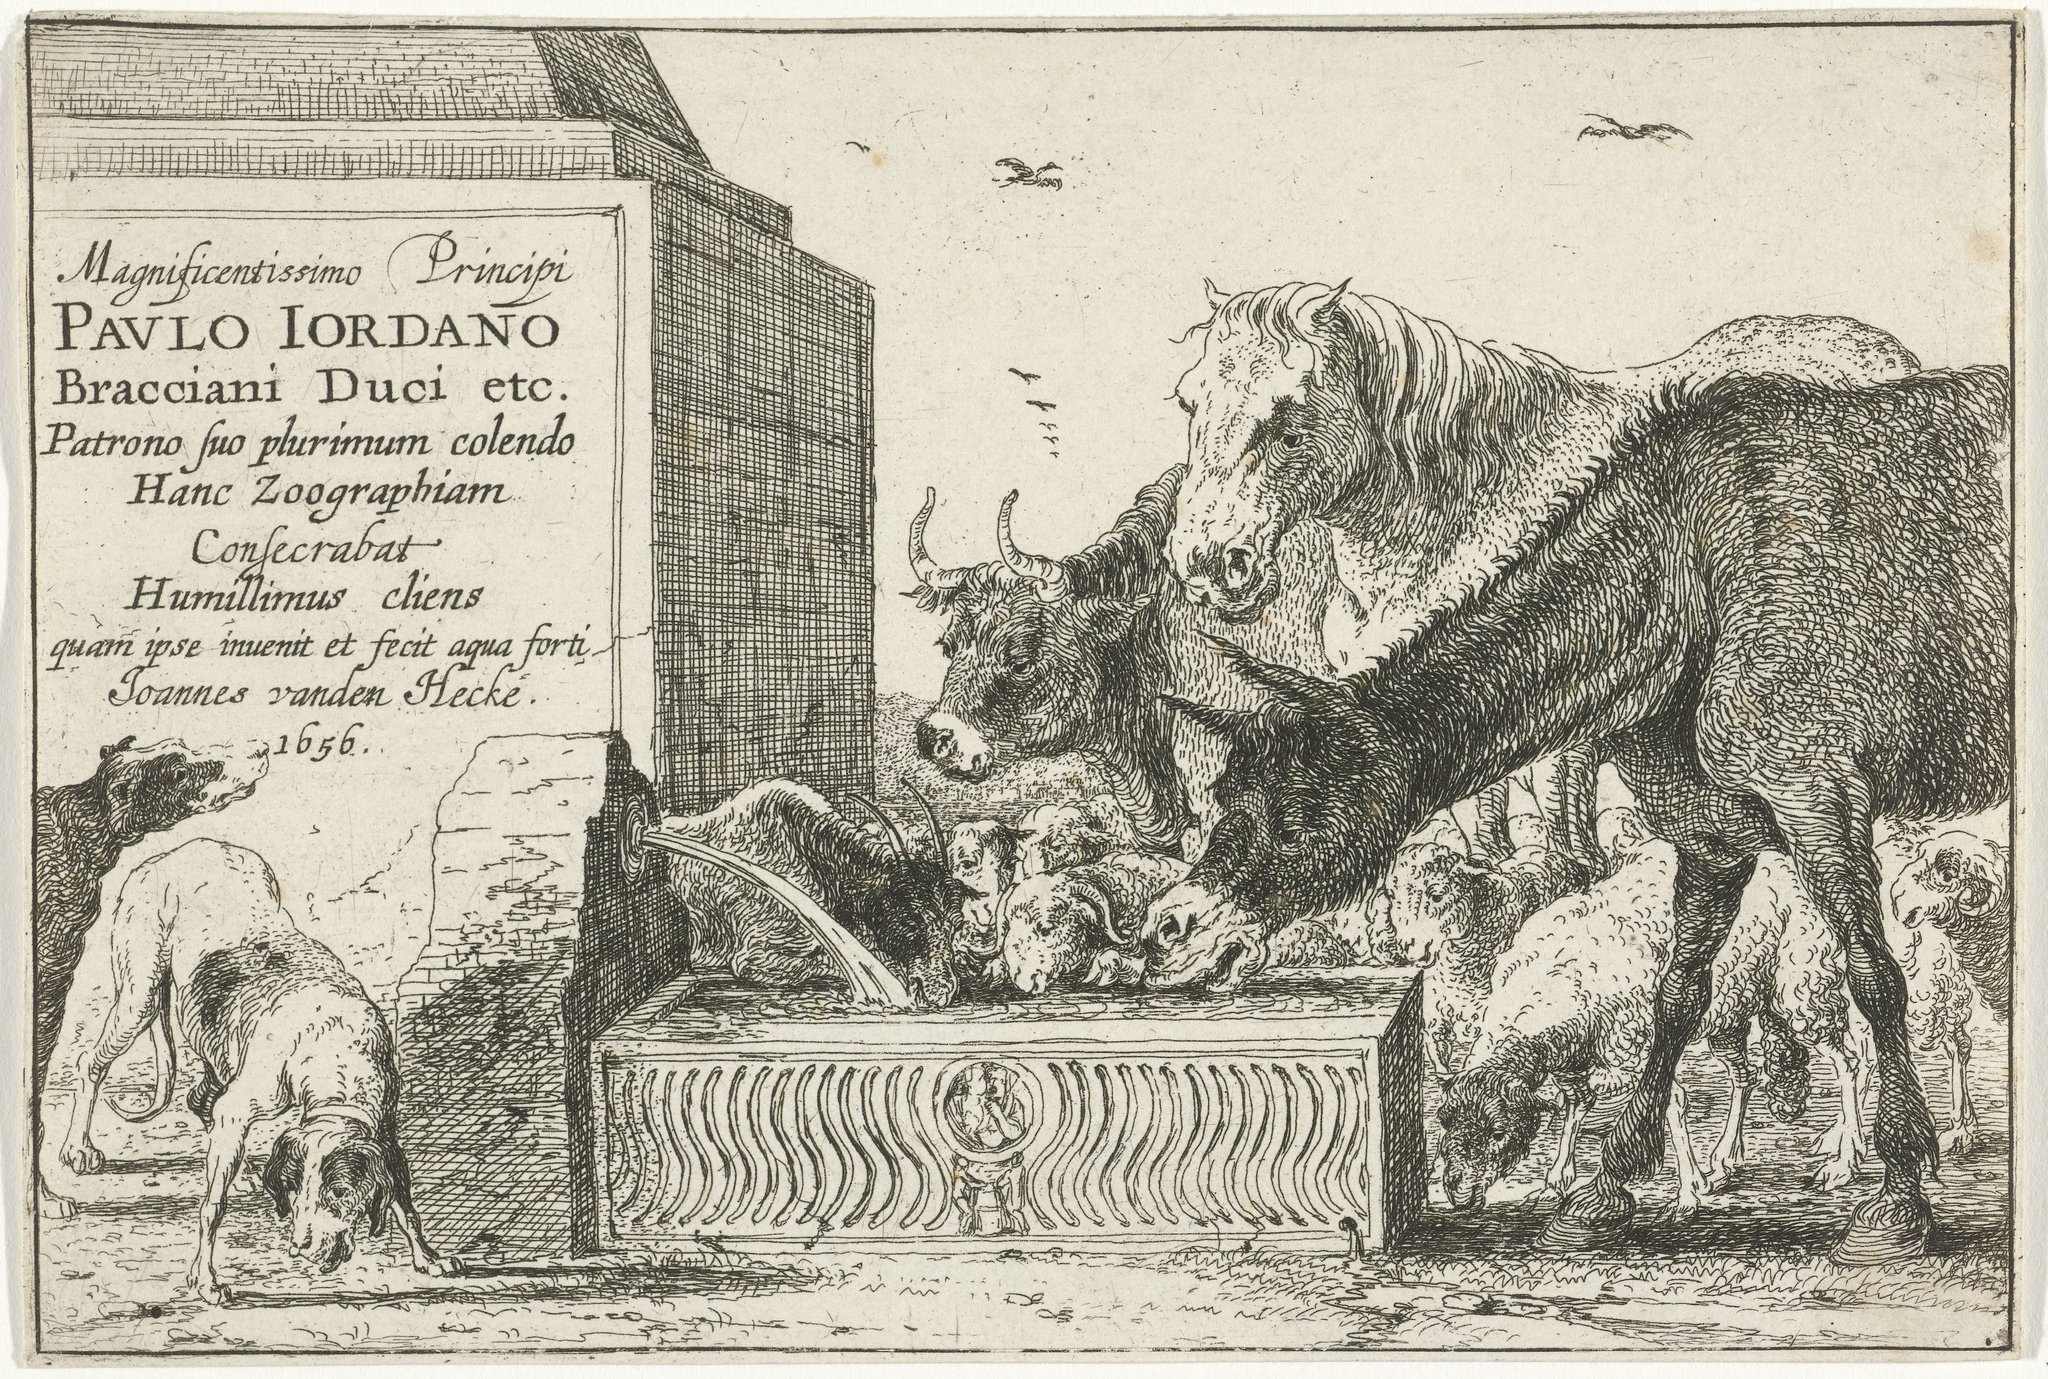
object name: titelprent, frontispice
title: Dieren bij een fontein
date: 1656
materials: paper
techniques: etching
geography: brussels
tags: horses and kindred animals, cow, sheep, goat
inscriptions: collector's mark: Lugt 913, collector's mark: Lugt 2228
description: Vee en honden bij een fontein. Links een stenen blok met de titel. Titelprent voor een serie van twaalf prenten met voorstellingen van dieren die voorkomen op een boeren bedrijf.